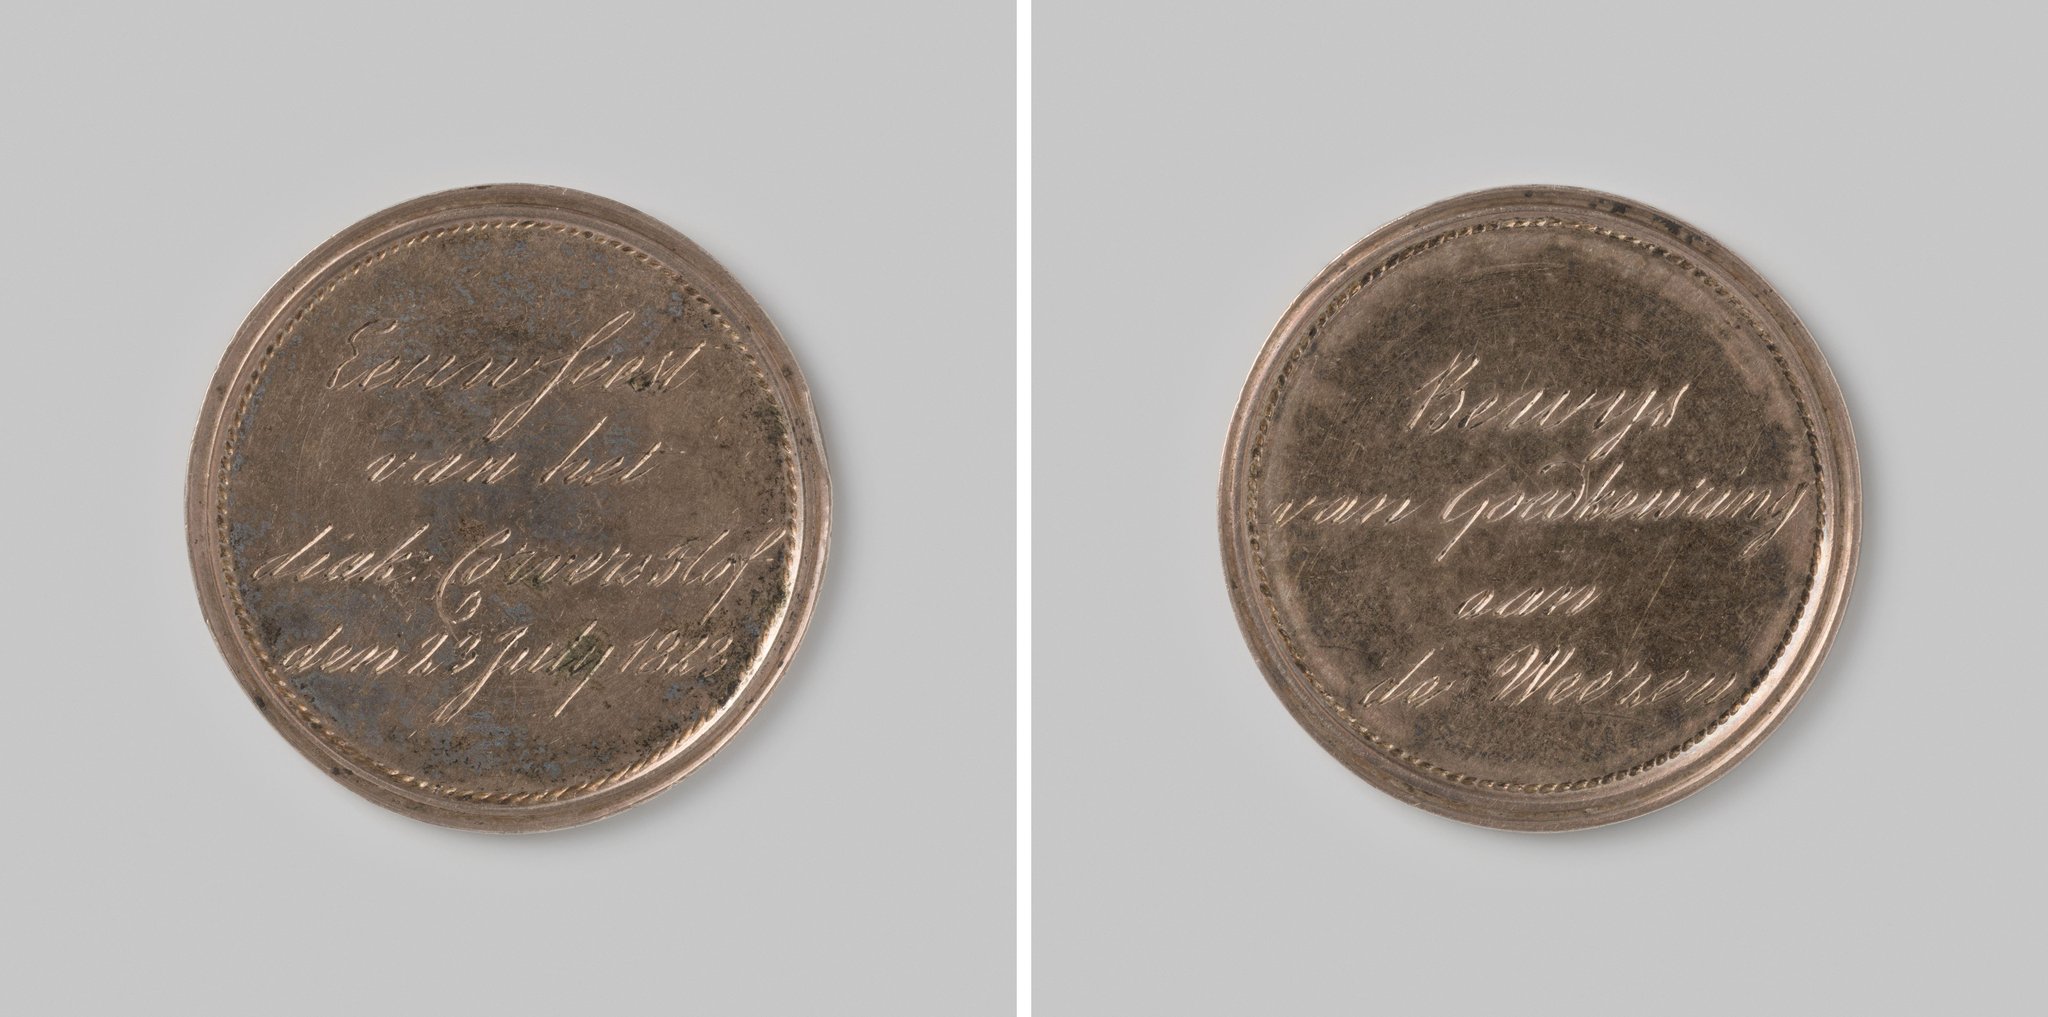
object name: history medal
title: Beloningspenning voor de wezen bij het honderdjarig bestaan van het Diaconie Corvershof te Amsterdam 1823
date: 1823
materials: silver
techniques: engraving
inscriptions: inscription: ‘Bewijs / van Goedkeuring / aan / de Weezen’, inscription: ‘Eeuwfeest / van het / diak. Corvers Hof / den 23 Julij 1823’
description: Zilveren penning, gedraaid zilveren plaatje met opstaande rand, waarin beiderzijds vier regels tekst en een stippelrand gegraveerd.